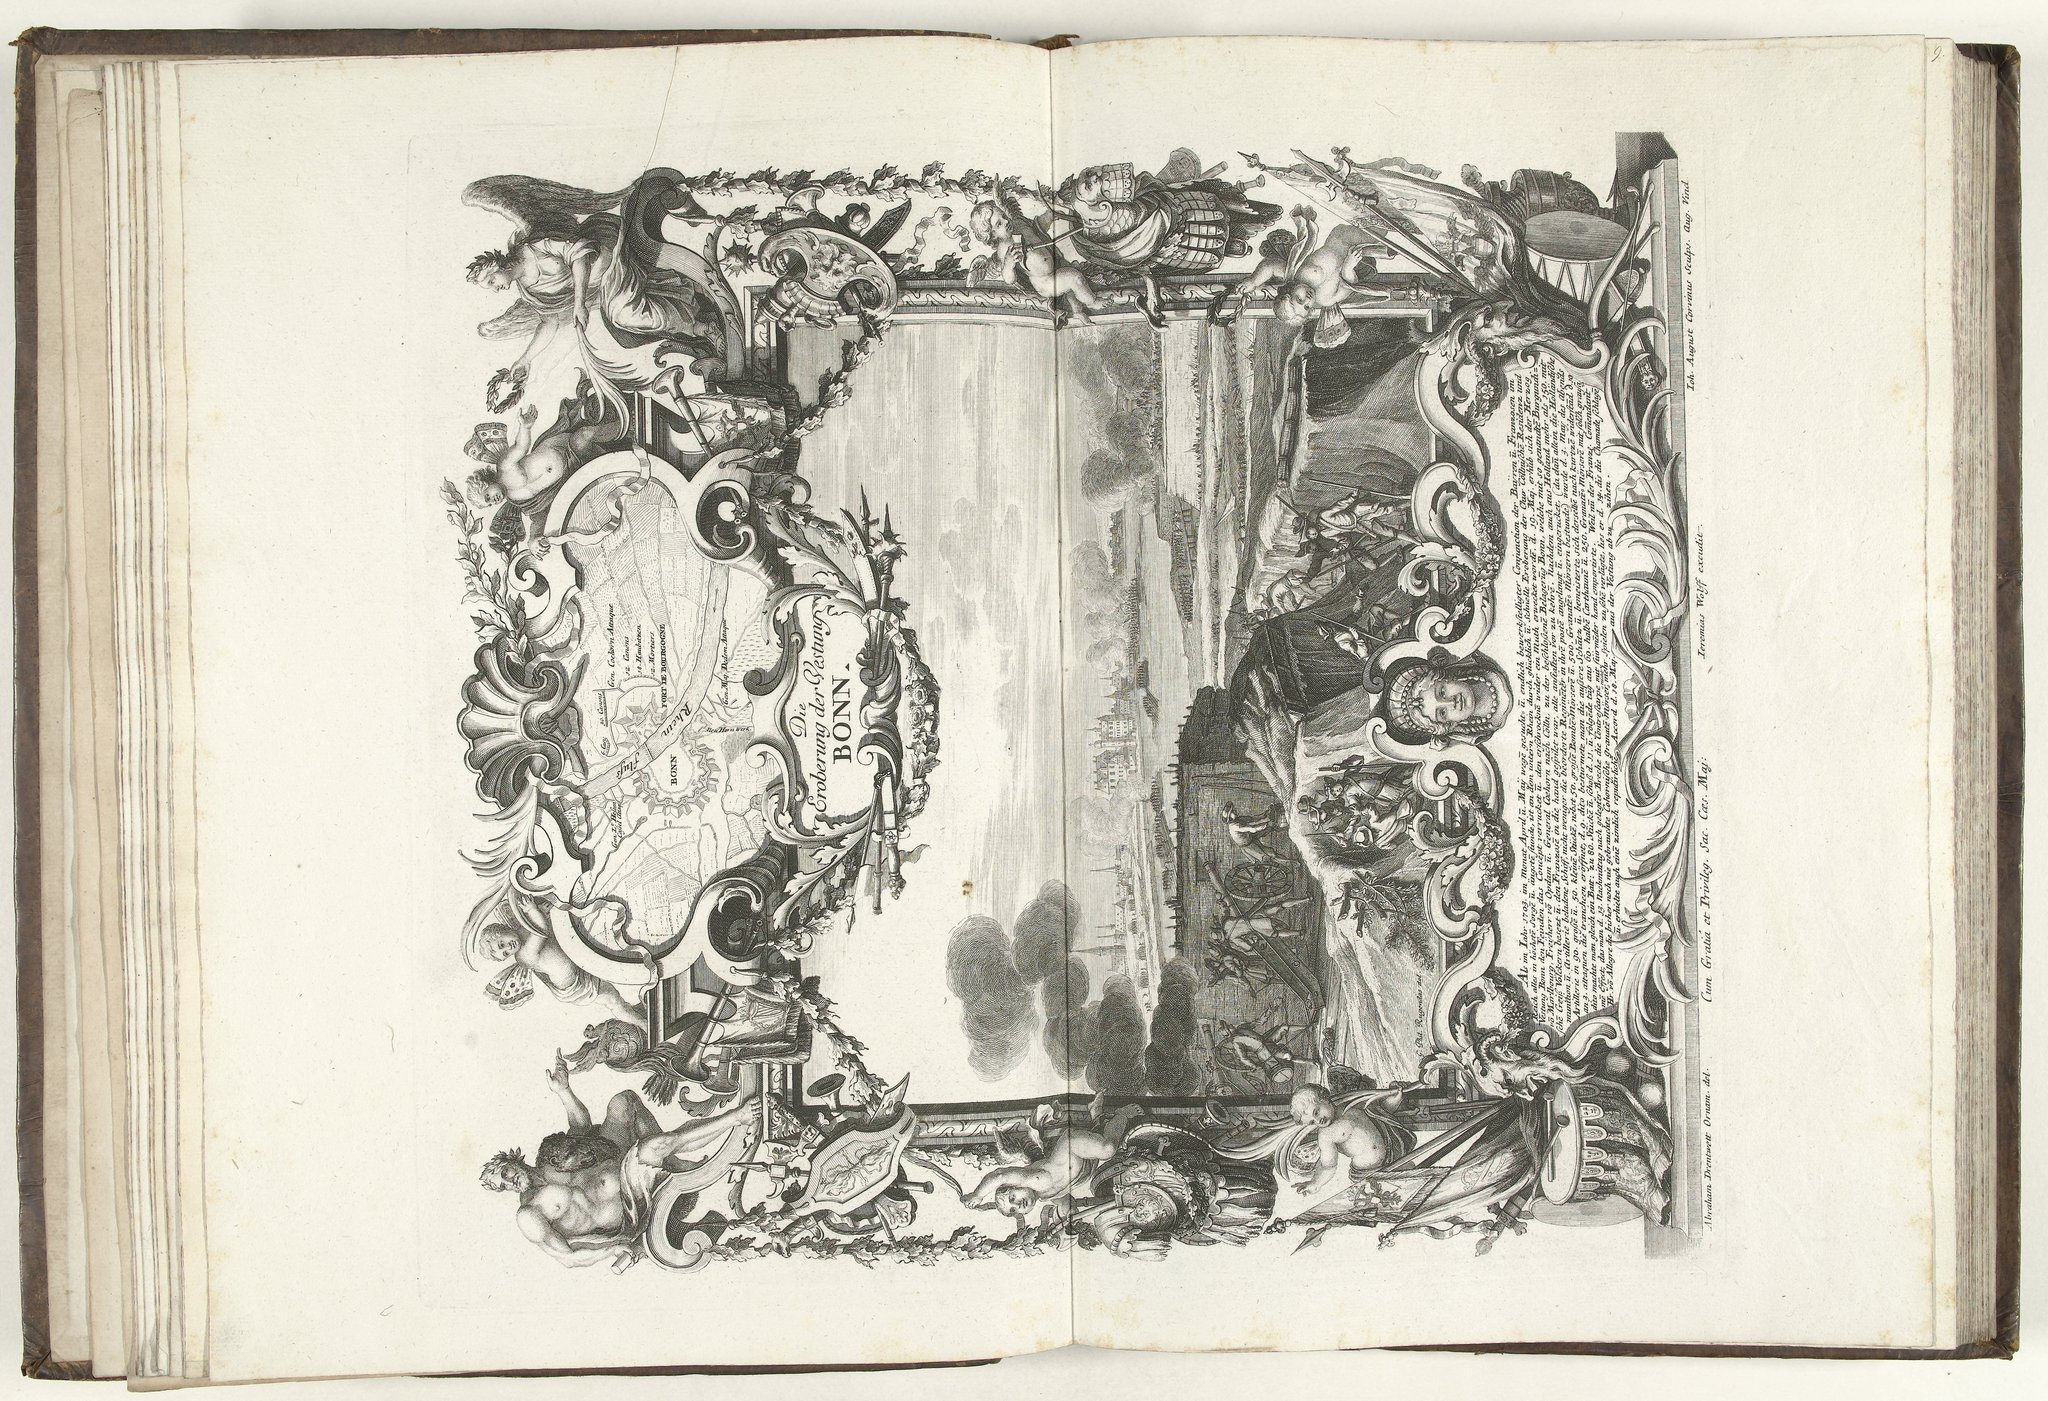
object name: history print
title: Inname van Bonn, 1703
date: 1712-1715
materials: paper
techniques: engraving, etching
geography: augsburg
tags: siege, position war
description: Verovering van Bonn op de Fransen door de bondgenoten op 15 mei 1703, na beleg vanaf 5 mei. De beschieting van de stad gezien vanuit de loopgraven van de Geallieerden. Voorstelling in een rijk versierde ornamentele omlijsting met met bovenaan een plattegrond van de stad. Onderaan in het midden een cartouche met een beschrijving van de gevechten in het Duits. Blad in de gebonden verzameling platen uitgebracht onder de titel: Repraesentatio belli ... Der Spanische Successions-Krieg [ca. 1720].